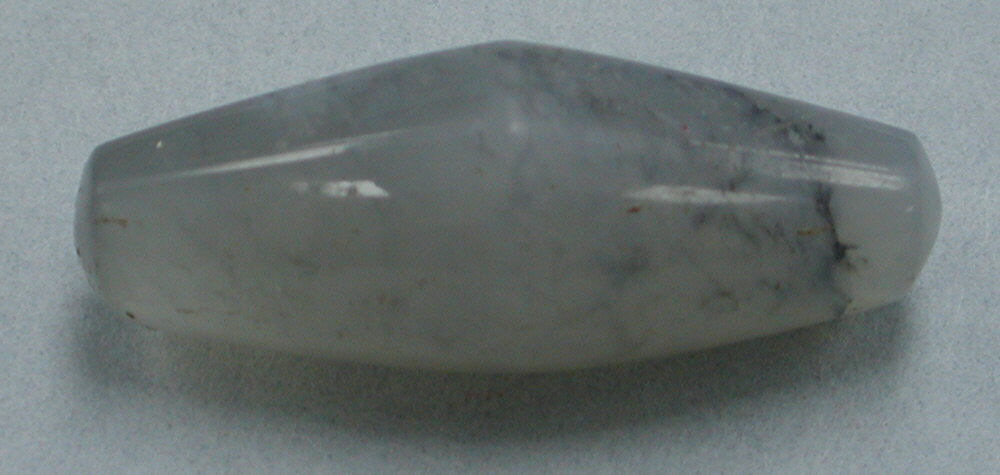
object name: ritual stone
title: Polishing Stone (pulidor)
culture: mexican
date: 1501-1600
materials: stone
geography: mexico